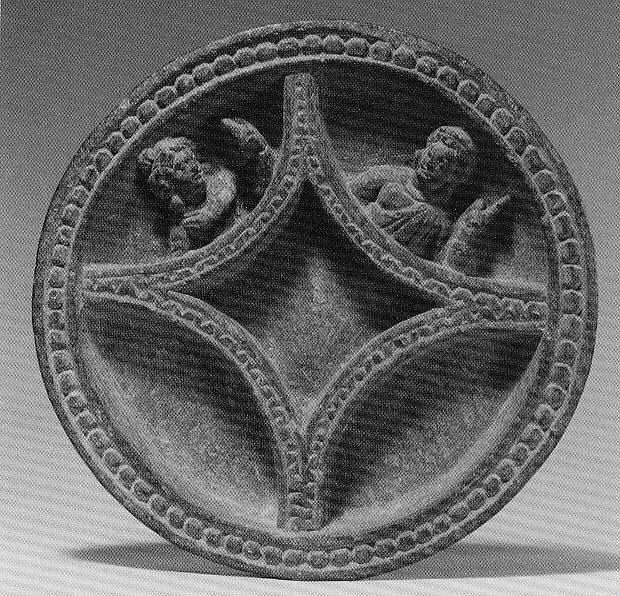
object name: dish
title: Dish with Busts of a Man and Woman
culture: gandhara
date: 200-1 BCE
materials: stone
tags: gandhara,men,women